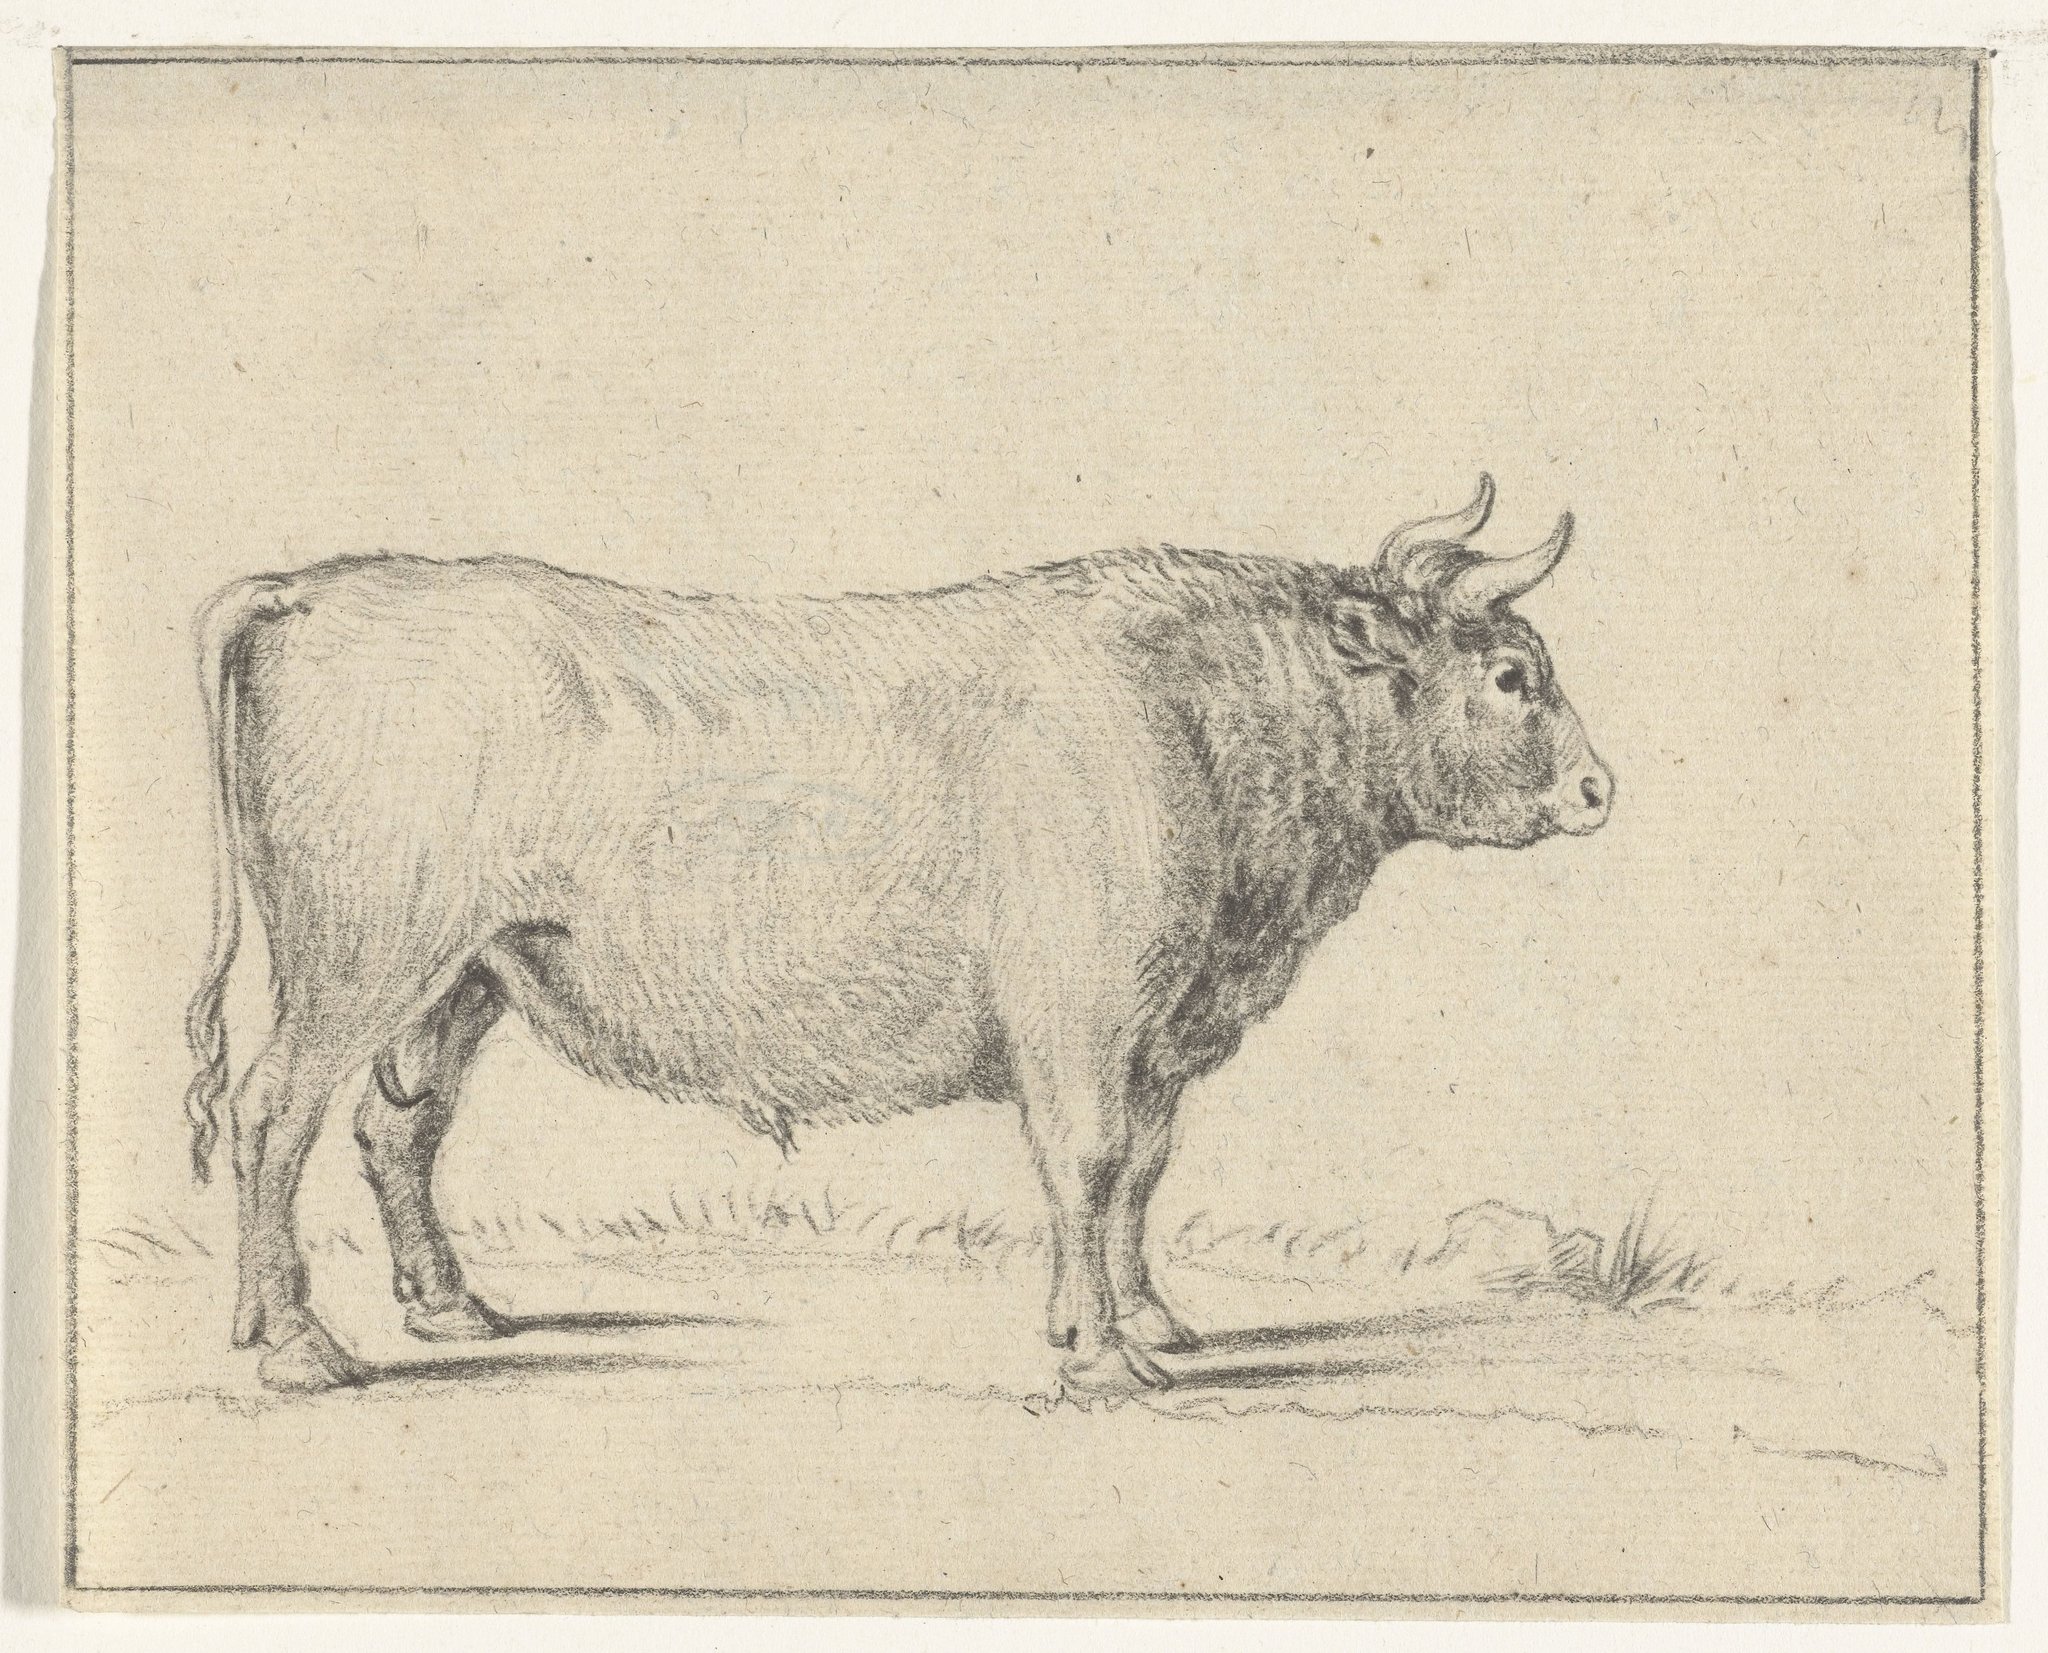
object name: drawing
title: Staande stier, naar rechts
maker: jean bernard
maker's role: draughtsman, print maker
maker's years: 1765-1833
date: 1775-1833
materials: chalk, paper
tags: bull